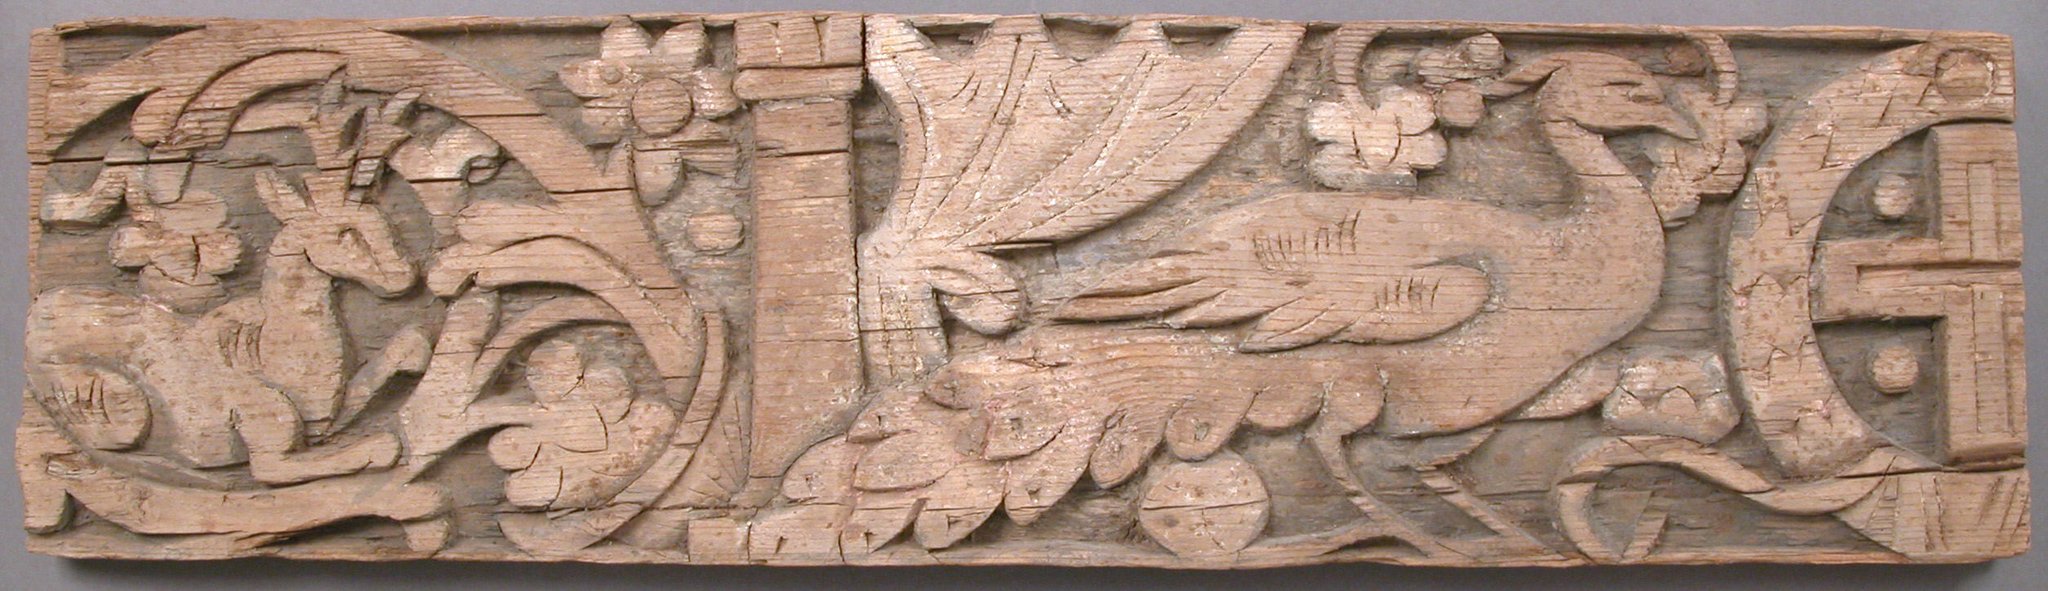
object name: relief frieze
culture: coptic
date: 501-600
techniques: polychromy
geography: egypt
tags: birds